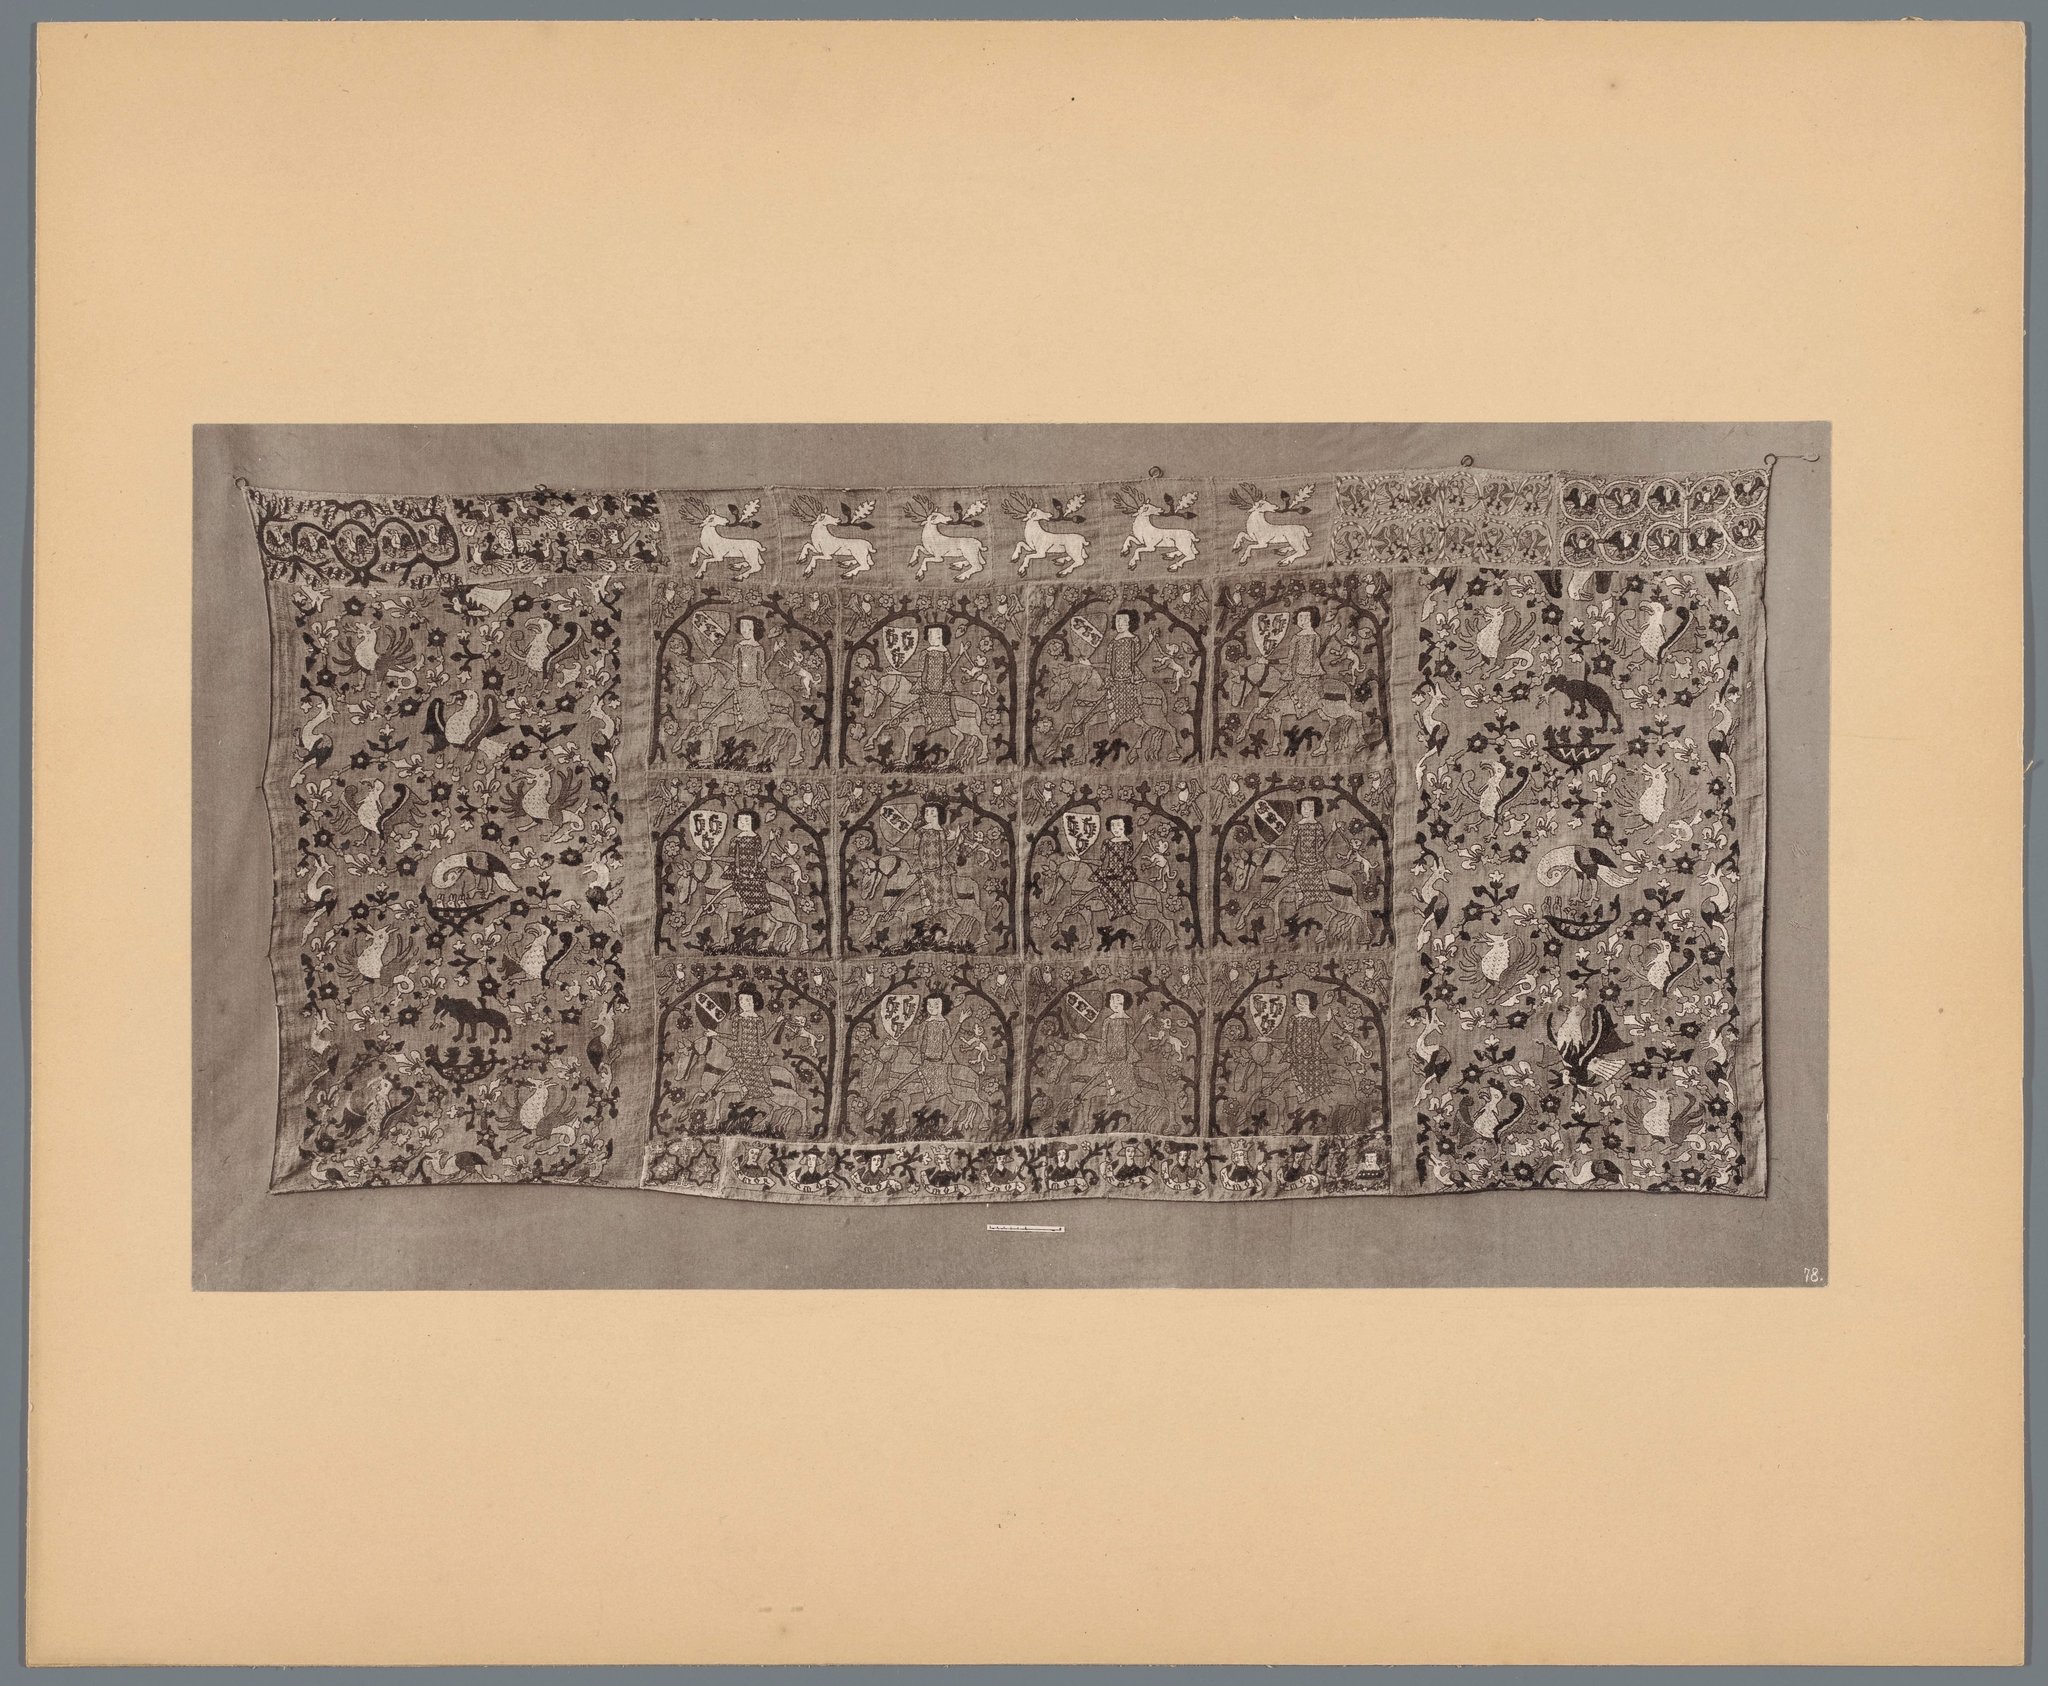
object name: photograph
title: Tapijt gedecoreerd met twaalf ruiters met wapenschilden en dieren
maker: Anonymous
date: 1875-1900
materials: cardboard, paper, ink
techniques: photograph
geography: europe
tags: riding a horse, ass, or mule; rider, horseman, coat of arms (as symbol of the state, etc.), tapestry, europe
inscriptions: number: ‘78.’, collector's mark: Lugt 3937